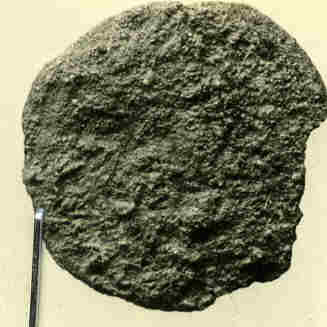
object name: coin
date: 758-768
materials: copper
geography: iran